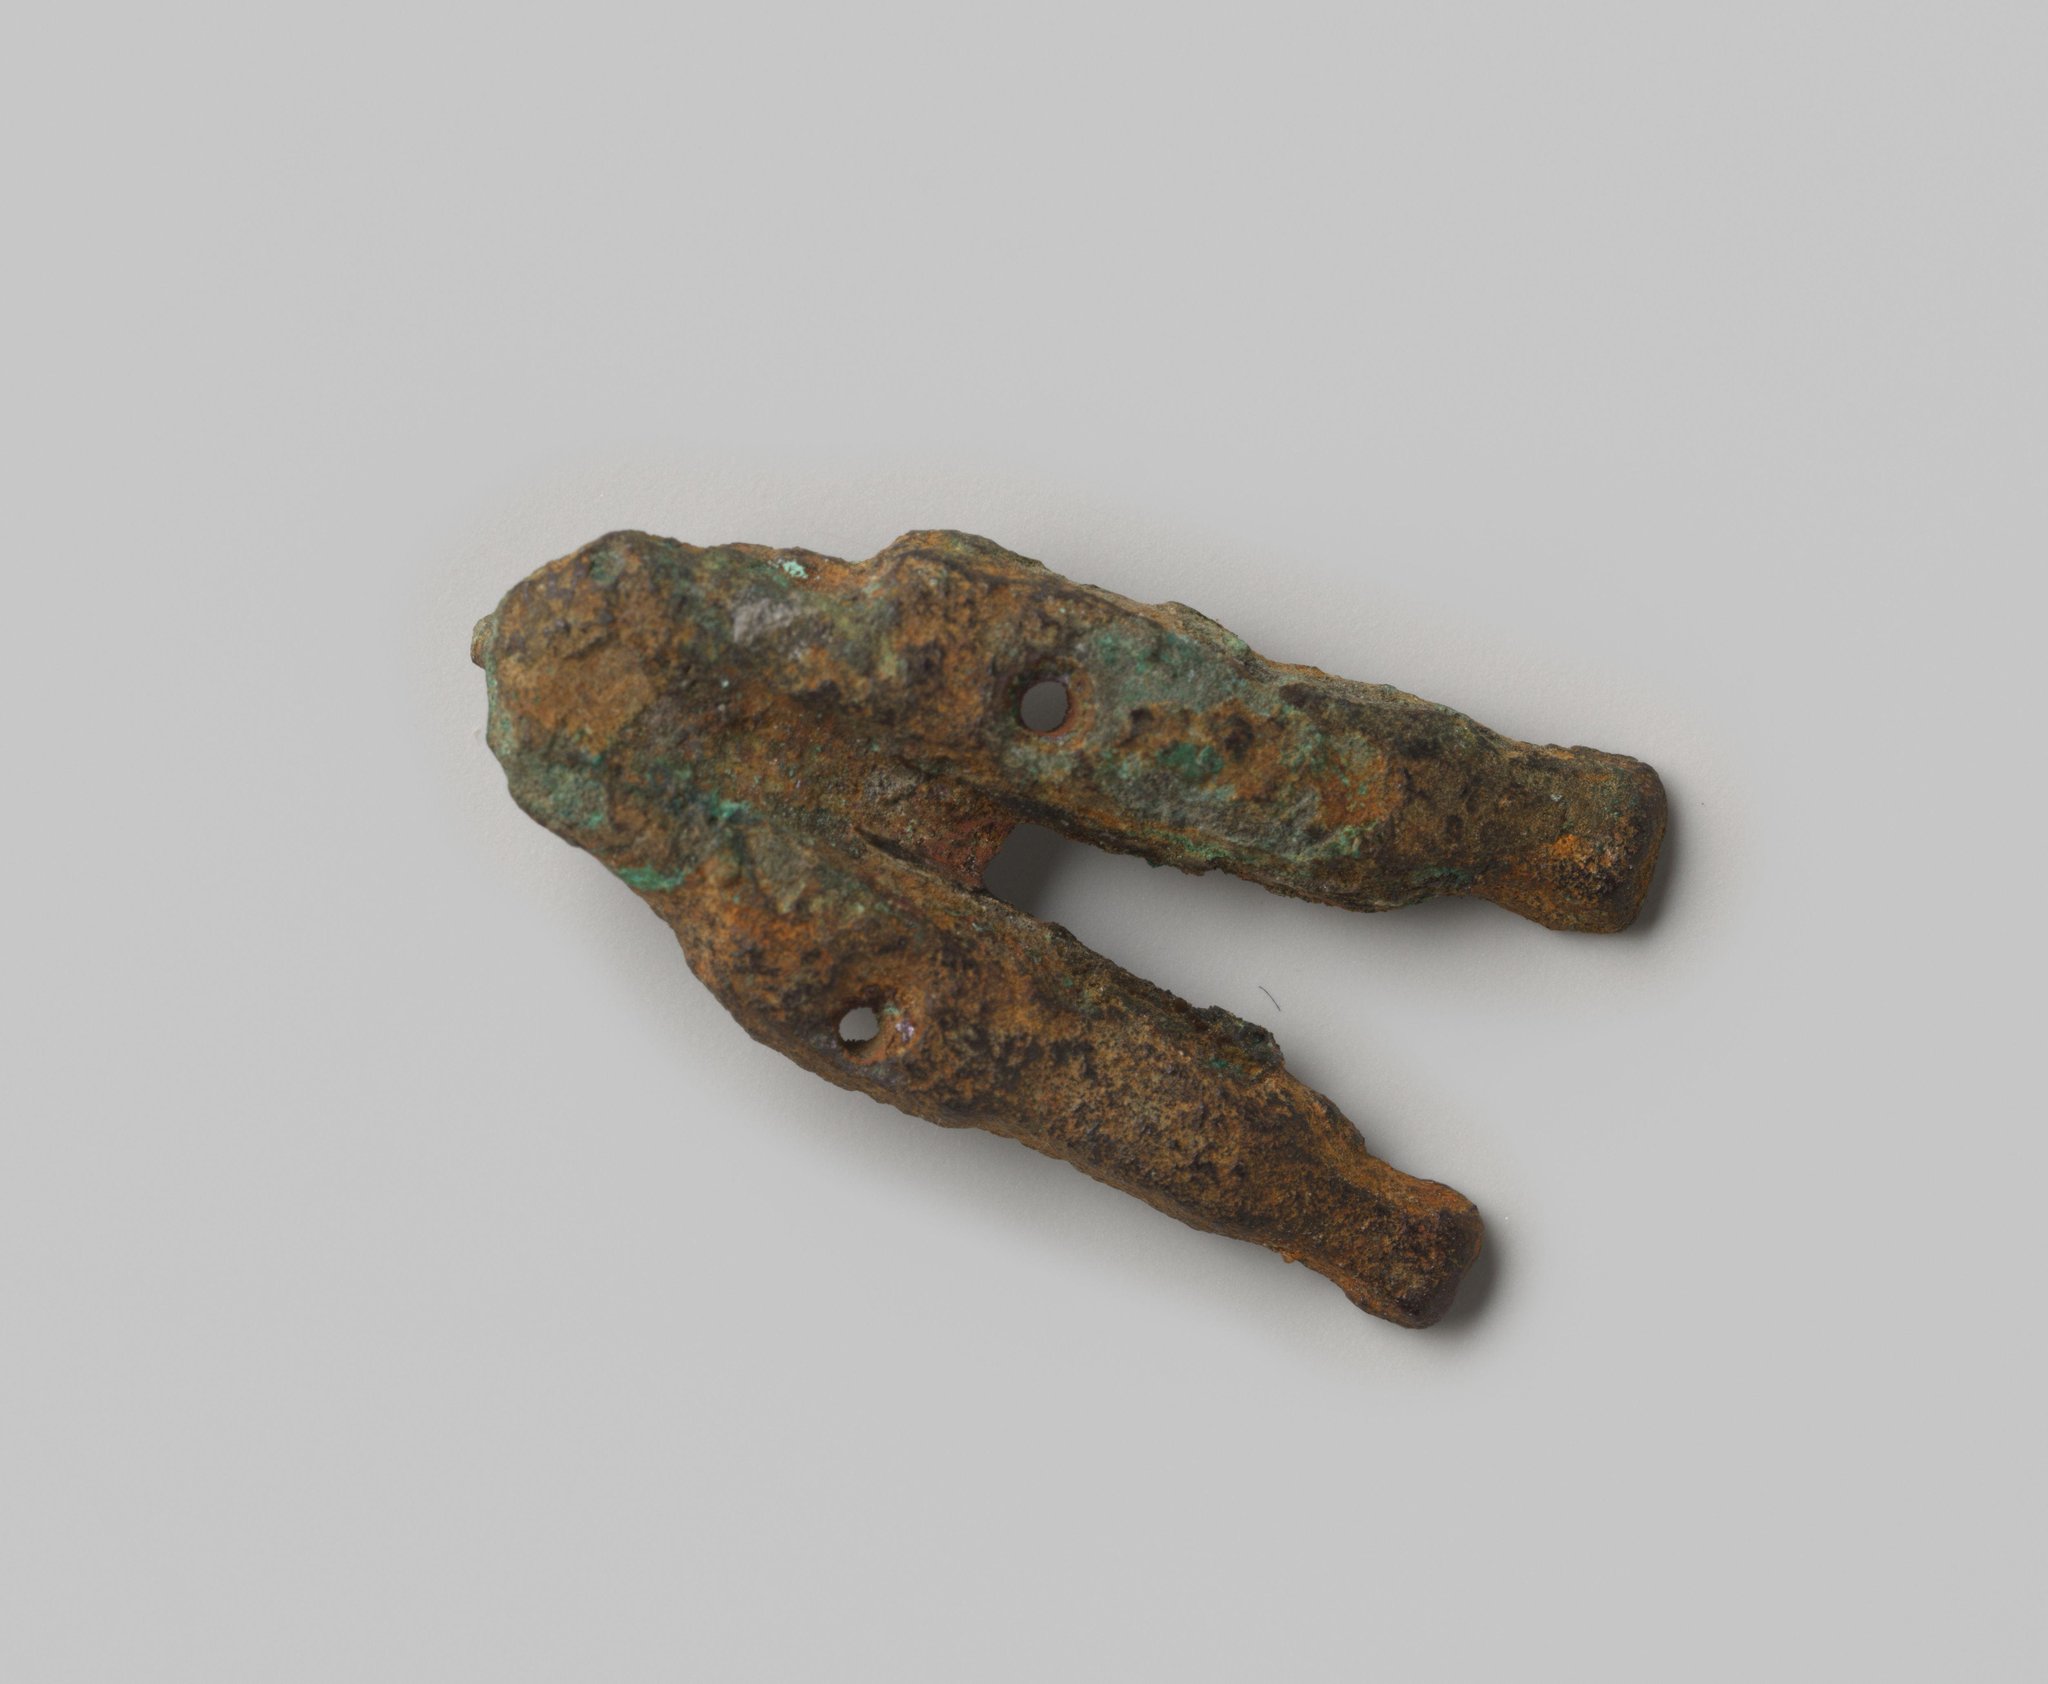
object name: sluitgewicht, pijlgewicht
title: Scharnier van een sluitgewicht uit het wrak van de Oost-Indiëvaarder Hollandia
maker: Anonymous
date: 1700-1743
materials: copper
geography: netherlands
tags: verenigde oostindische compagnie, hollandia (schip), annet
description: Weight, cupweight, locks and hinges; fragm of hinge, id. NG 1980-27H84.